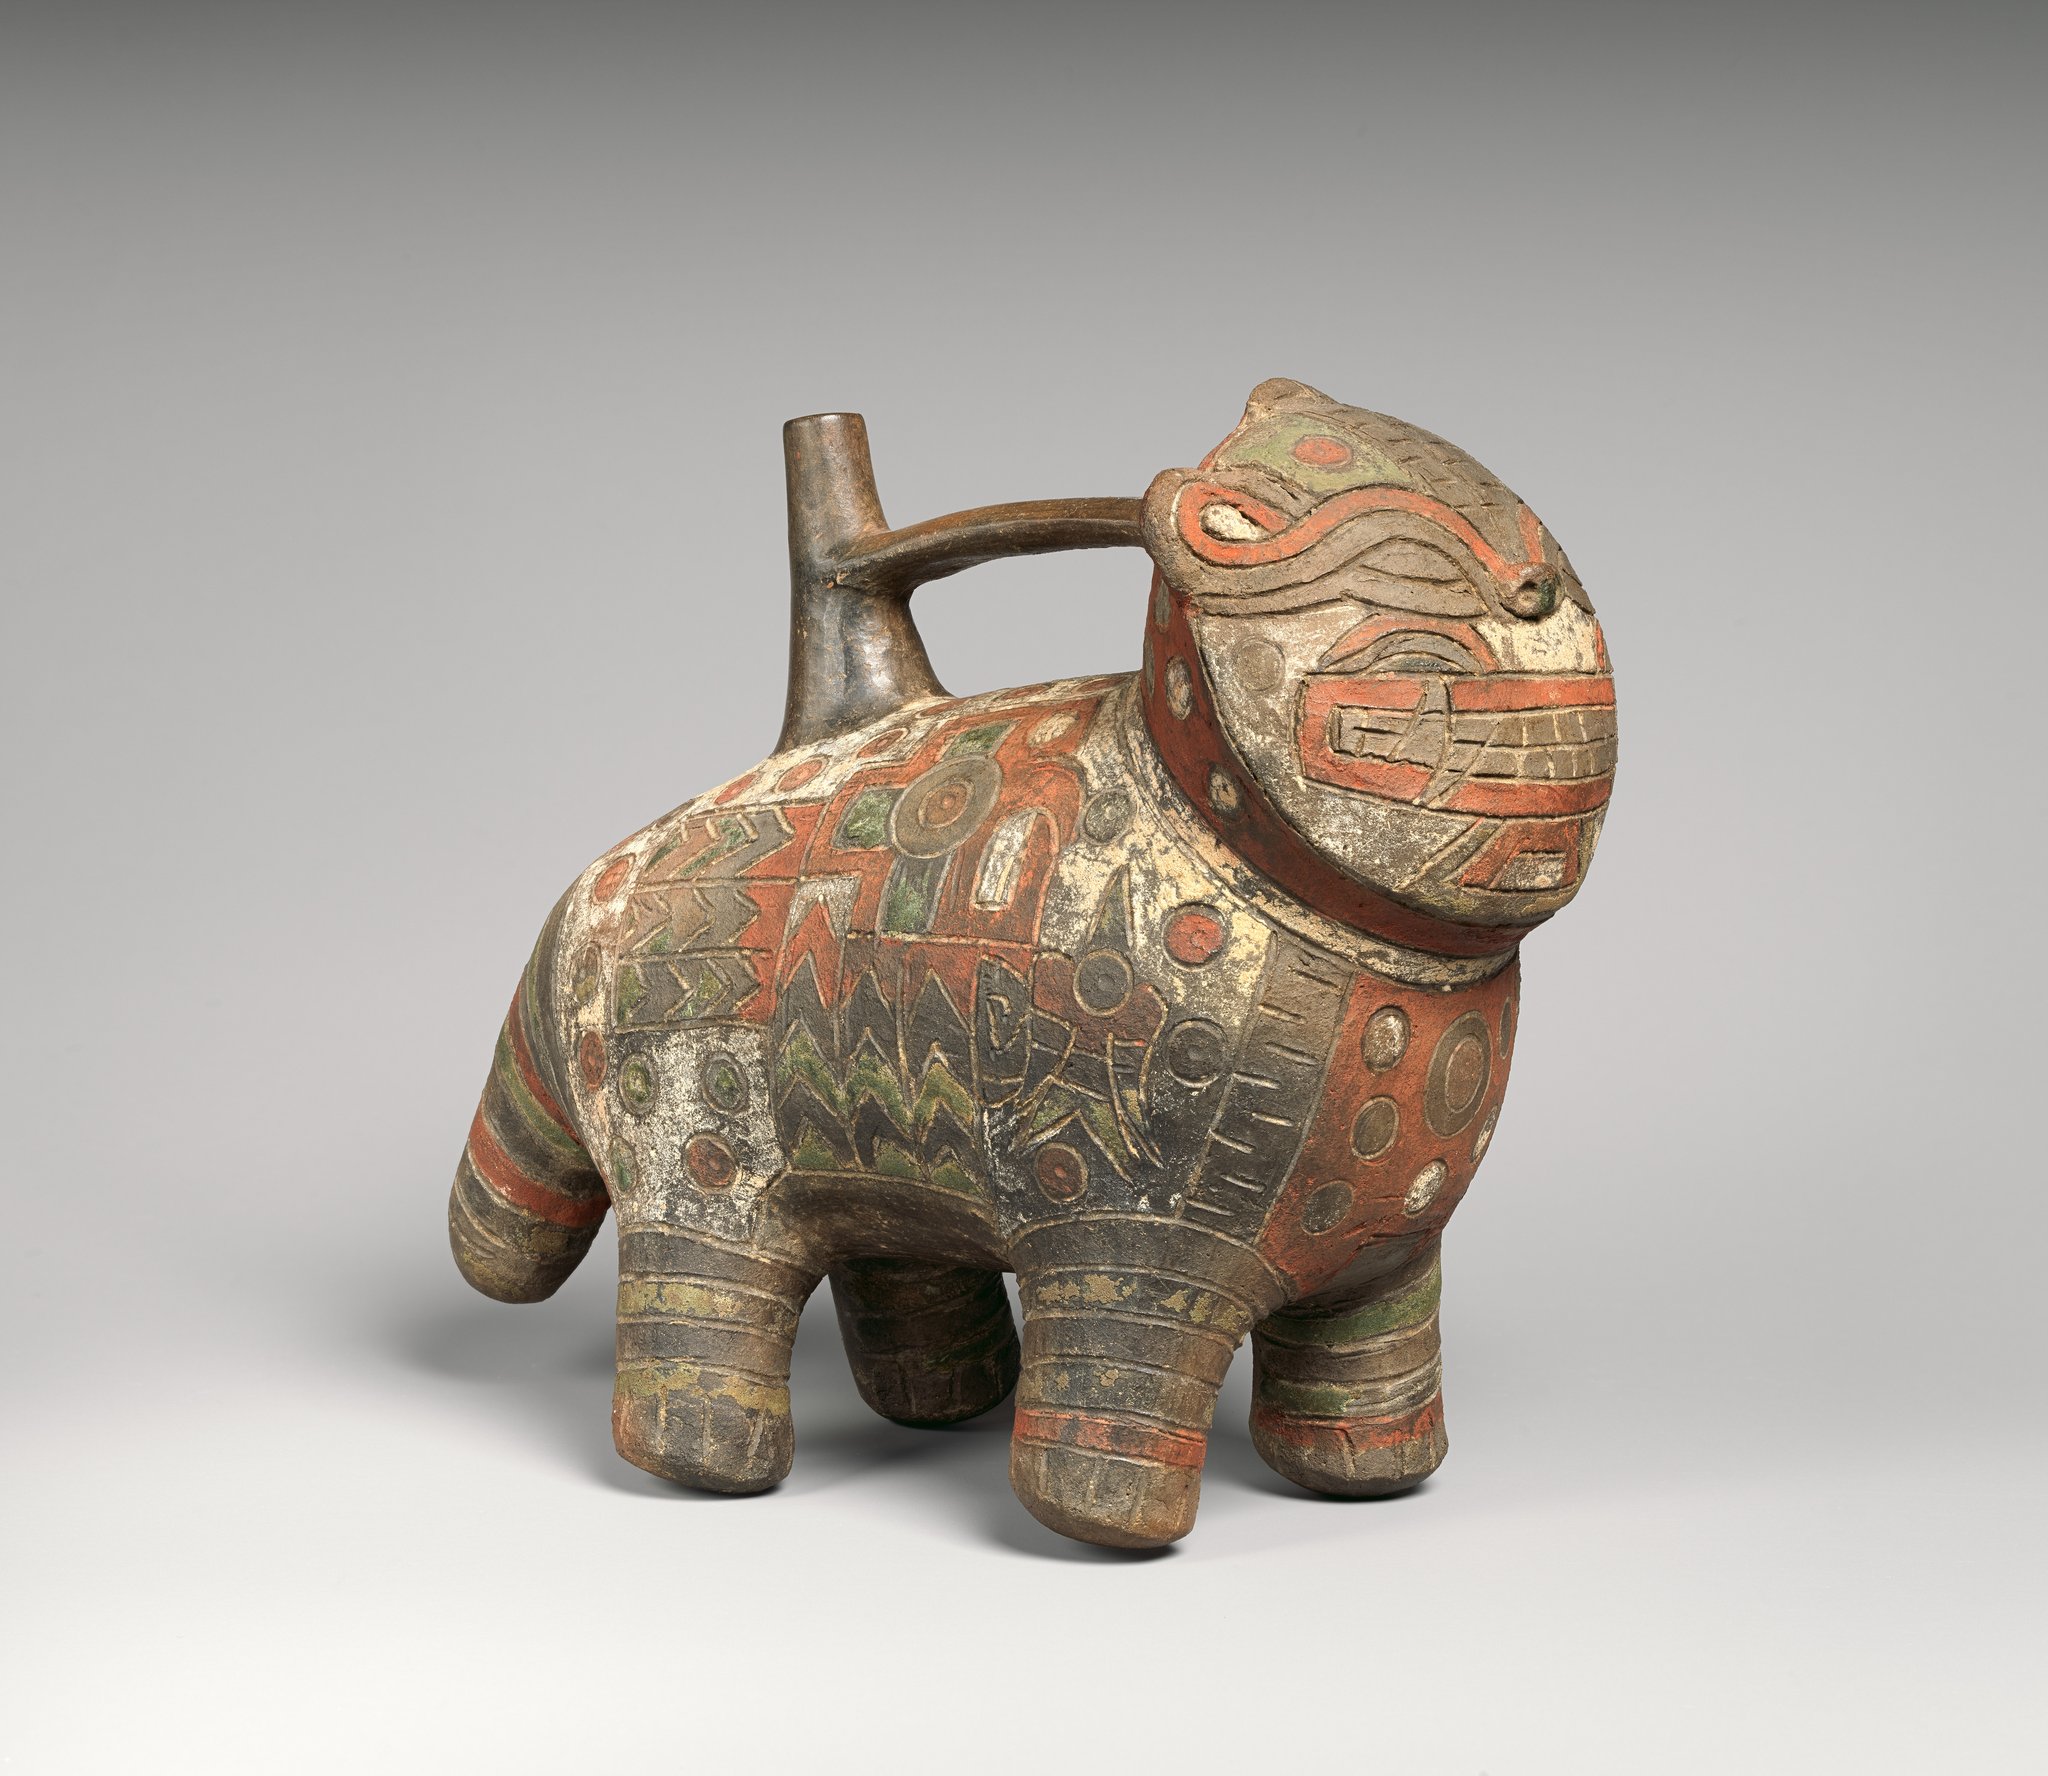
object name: bottle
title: Feline-shaped spout-and-bridge bottle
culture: paracas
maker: paracas artist(s)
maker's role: artist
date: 800-400 BCE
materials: ceramic, paint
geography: peru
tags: animals